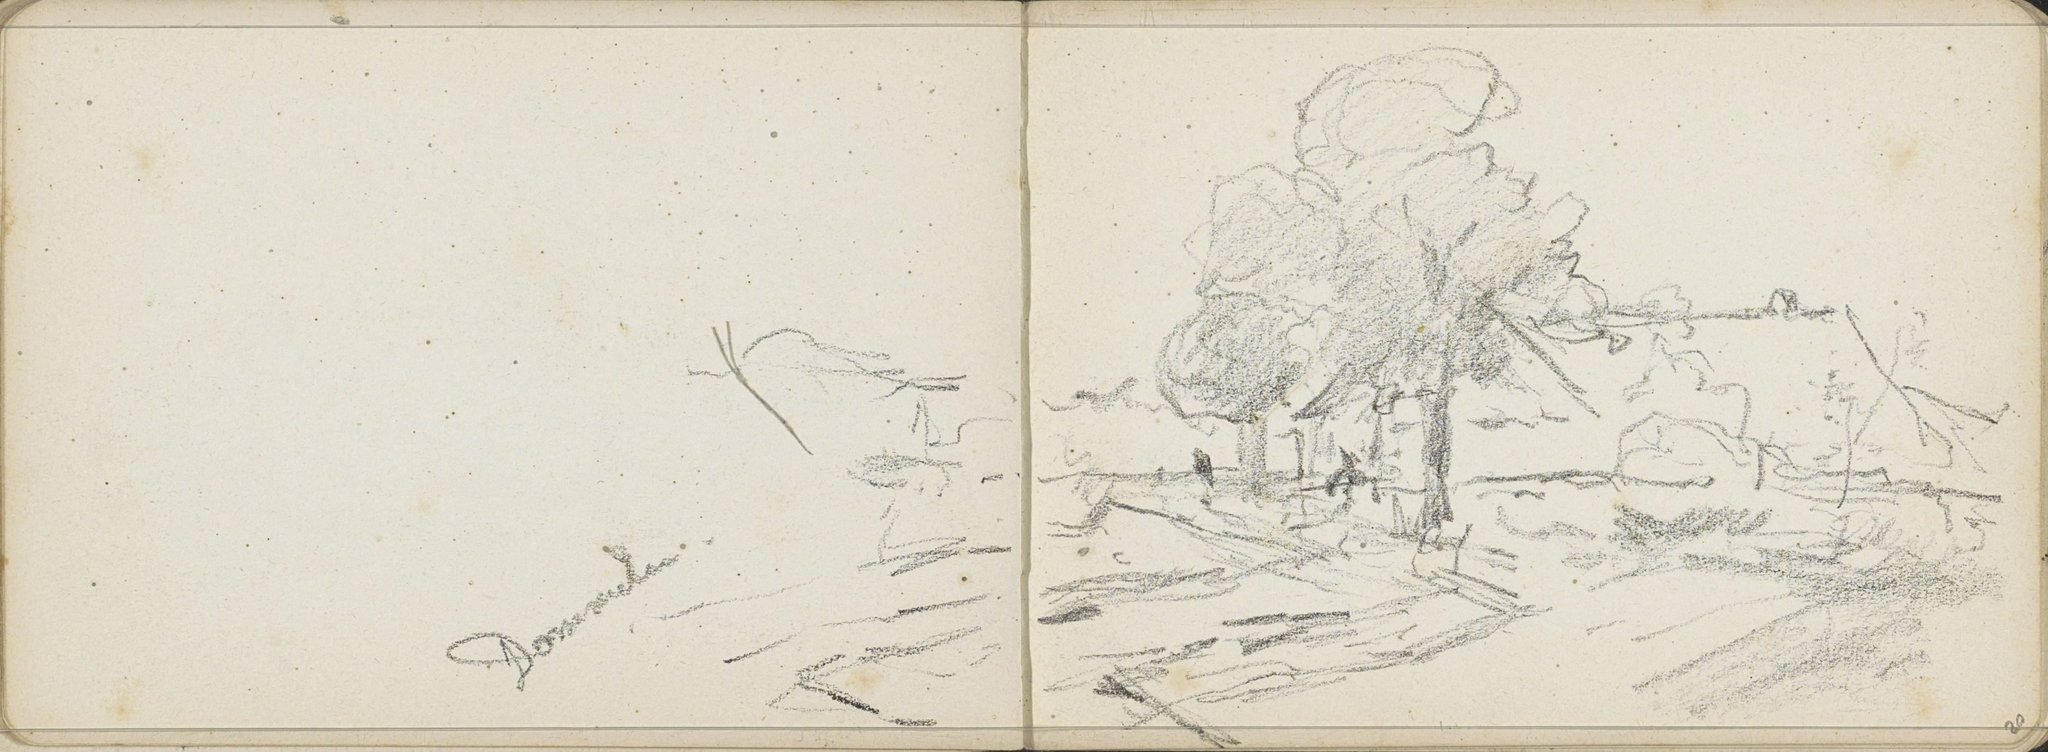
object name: sketchbook leaf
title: Huis aan een weg te Dommelen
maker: willem cornelis rip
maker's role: draughtsman, painter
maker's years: 1856-1922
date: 1866-1922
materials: chalk, paper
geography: dommelen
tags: road, path, farm or solitary house in landscape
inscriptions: annotation: ‘Dommelen.’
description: Blad 19 verso en 20 recto uit een schetsboek met 42 bladen.